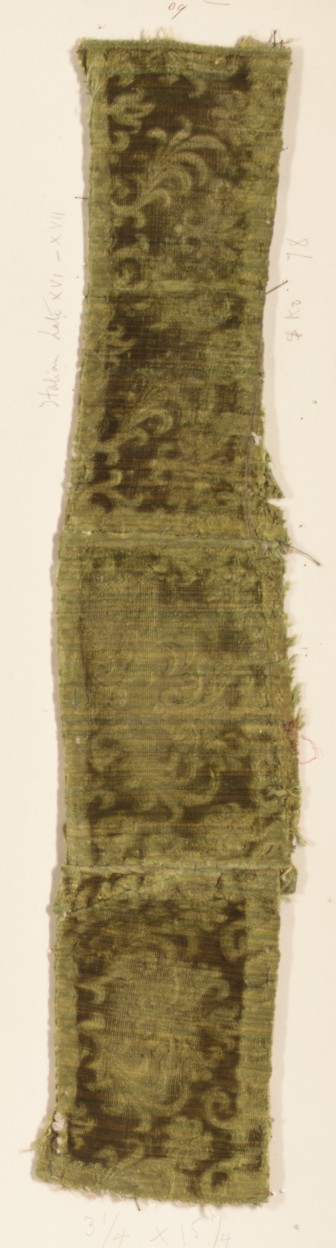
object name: fragment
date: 1567-1700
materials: silk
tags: leaves